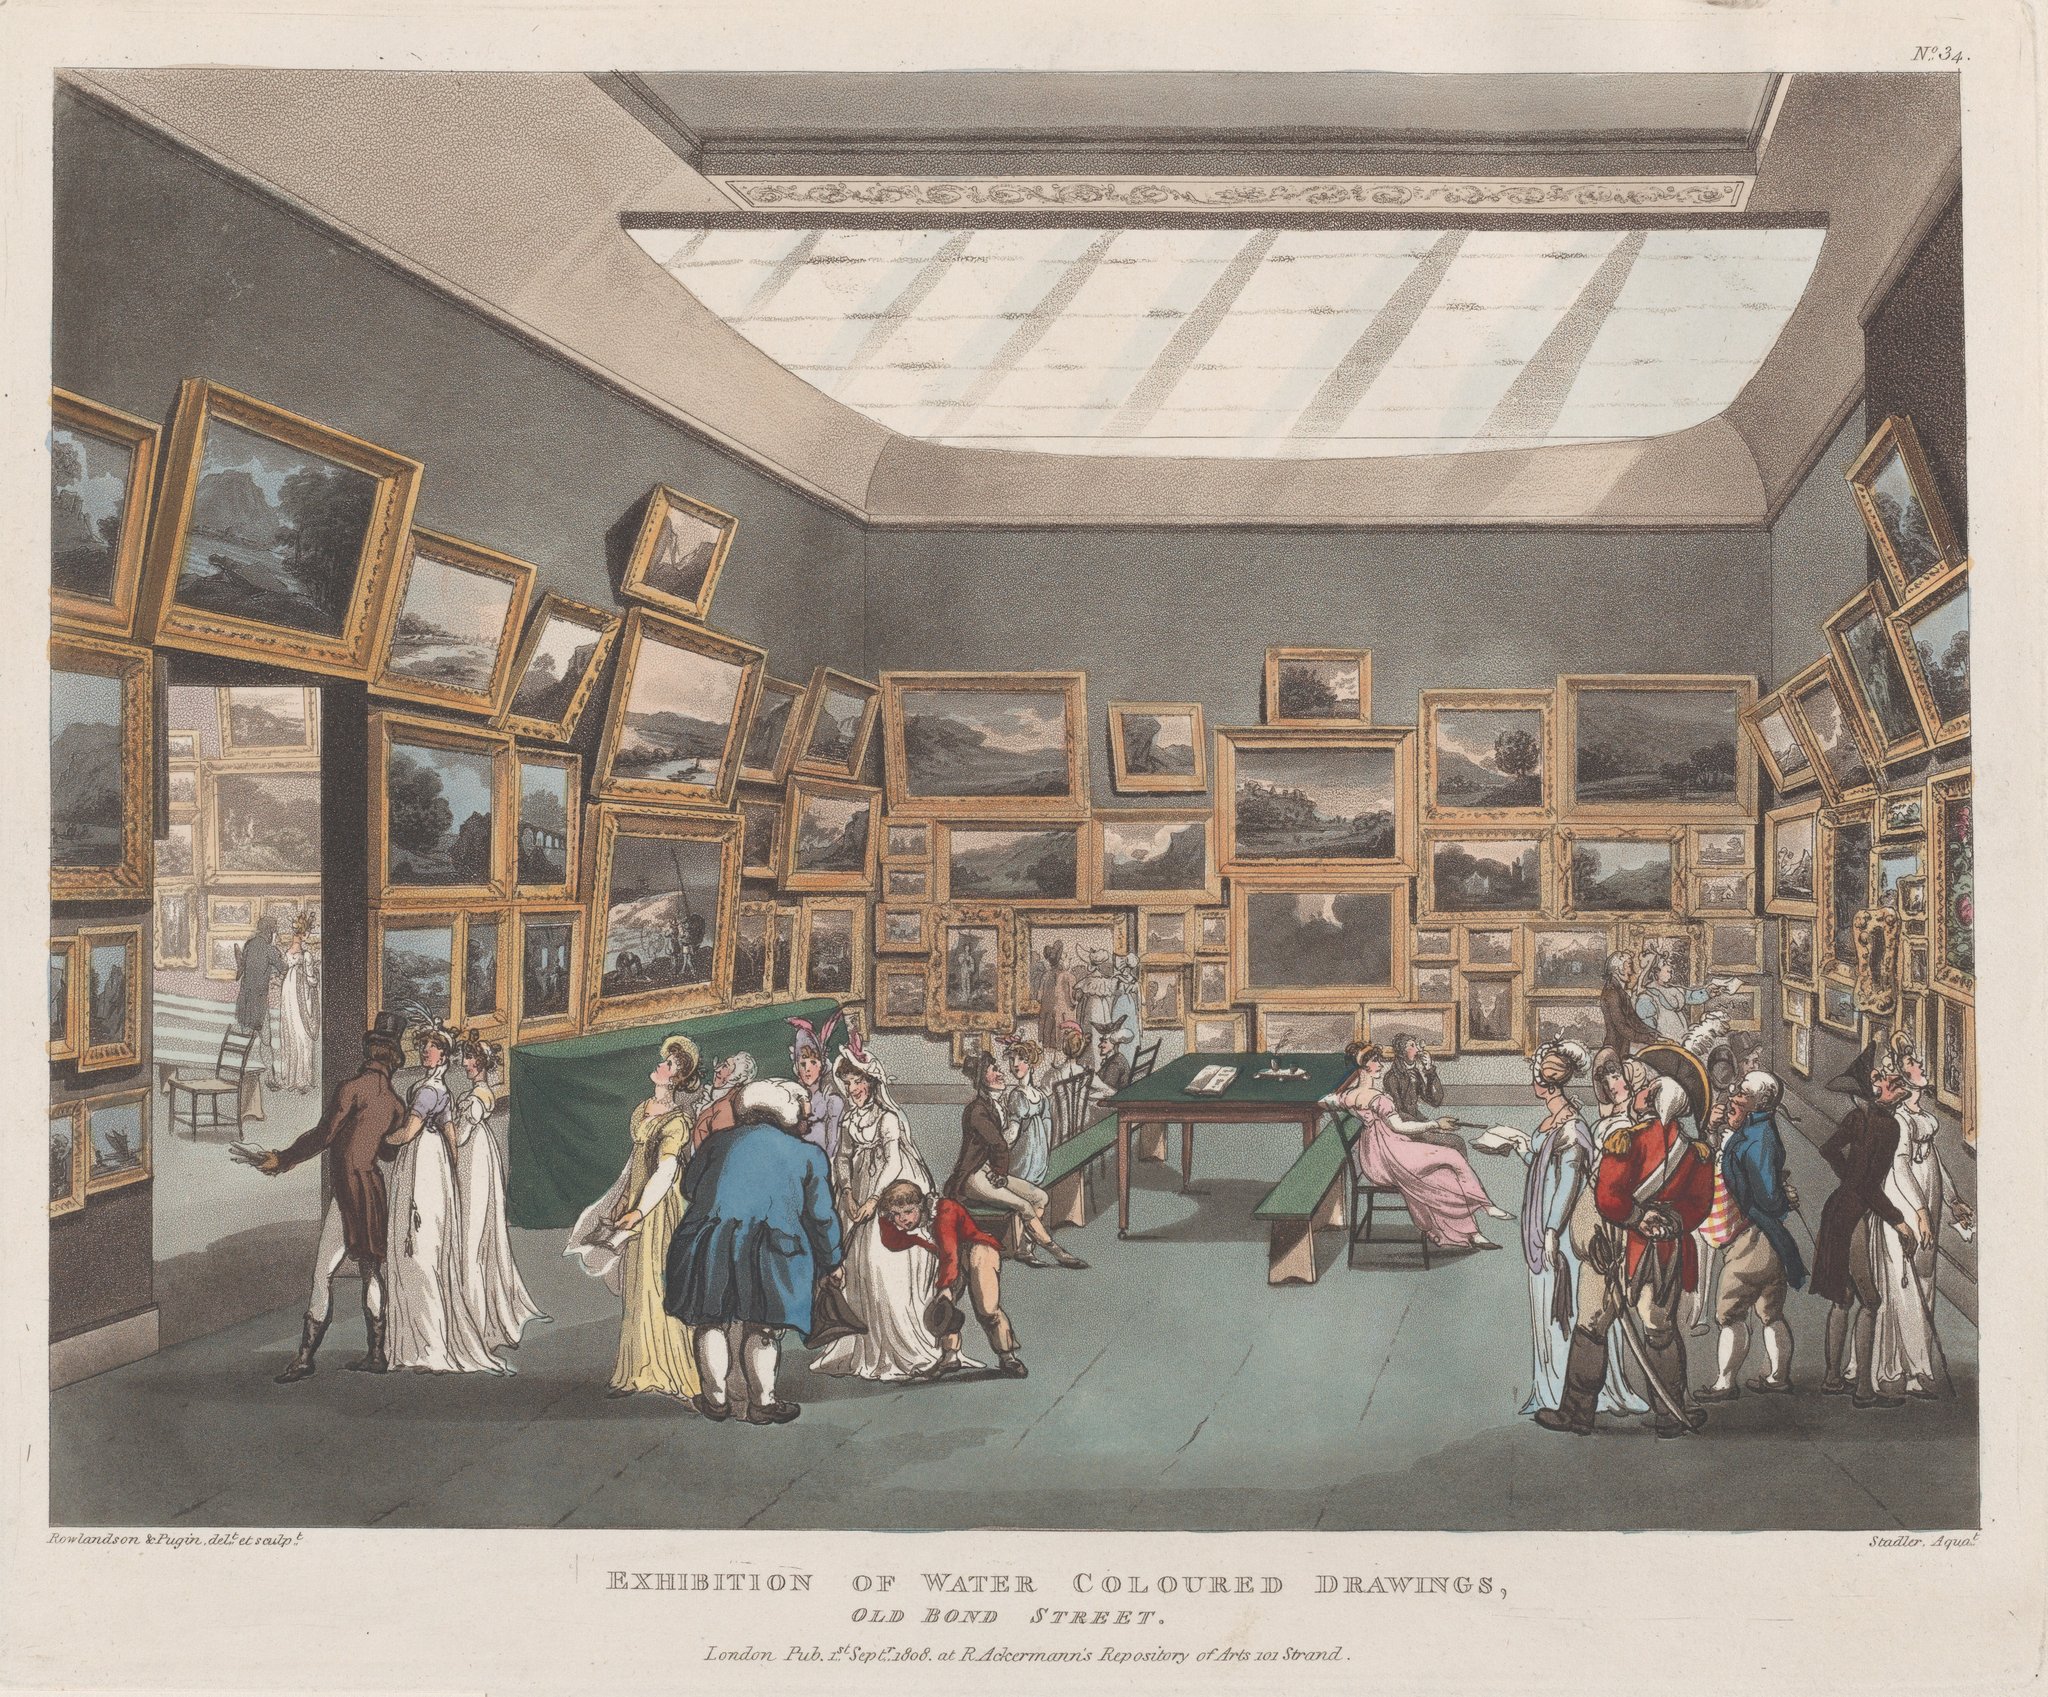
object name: print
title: Exhibition of Water Coloured Drawings, Old Bond Street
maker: thomas rowlandson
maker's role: artist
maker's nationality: british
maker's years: 1757-1827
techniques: aquatint, etching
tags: interiors,men,women